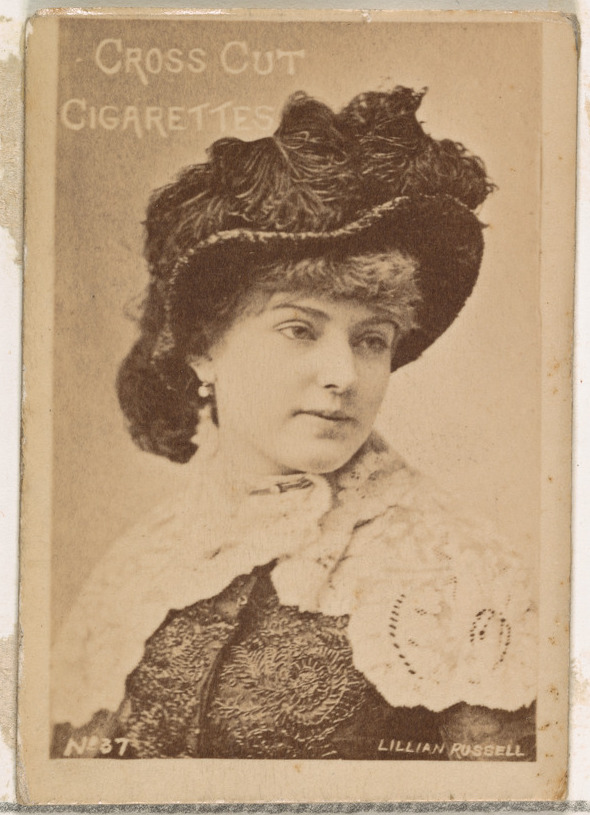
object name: print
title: Card Number 37, Lillian Russell, from the Actors and Actresses series (N145-1) issued by Duke Sons & Co. to promote Cross Cut Cigarettes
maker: w. duke, sons & co.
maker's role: publisher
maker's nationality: american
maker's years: 1870-1920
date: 1880-1889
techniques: albumen silver print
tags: portraits,women,actresses